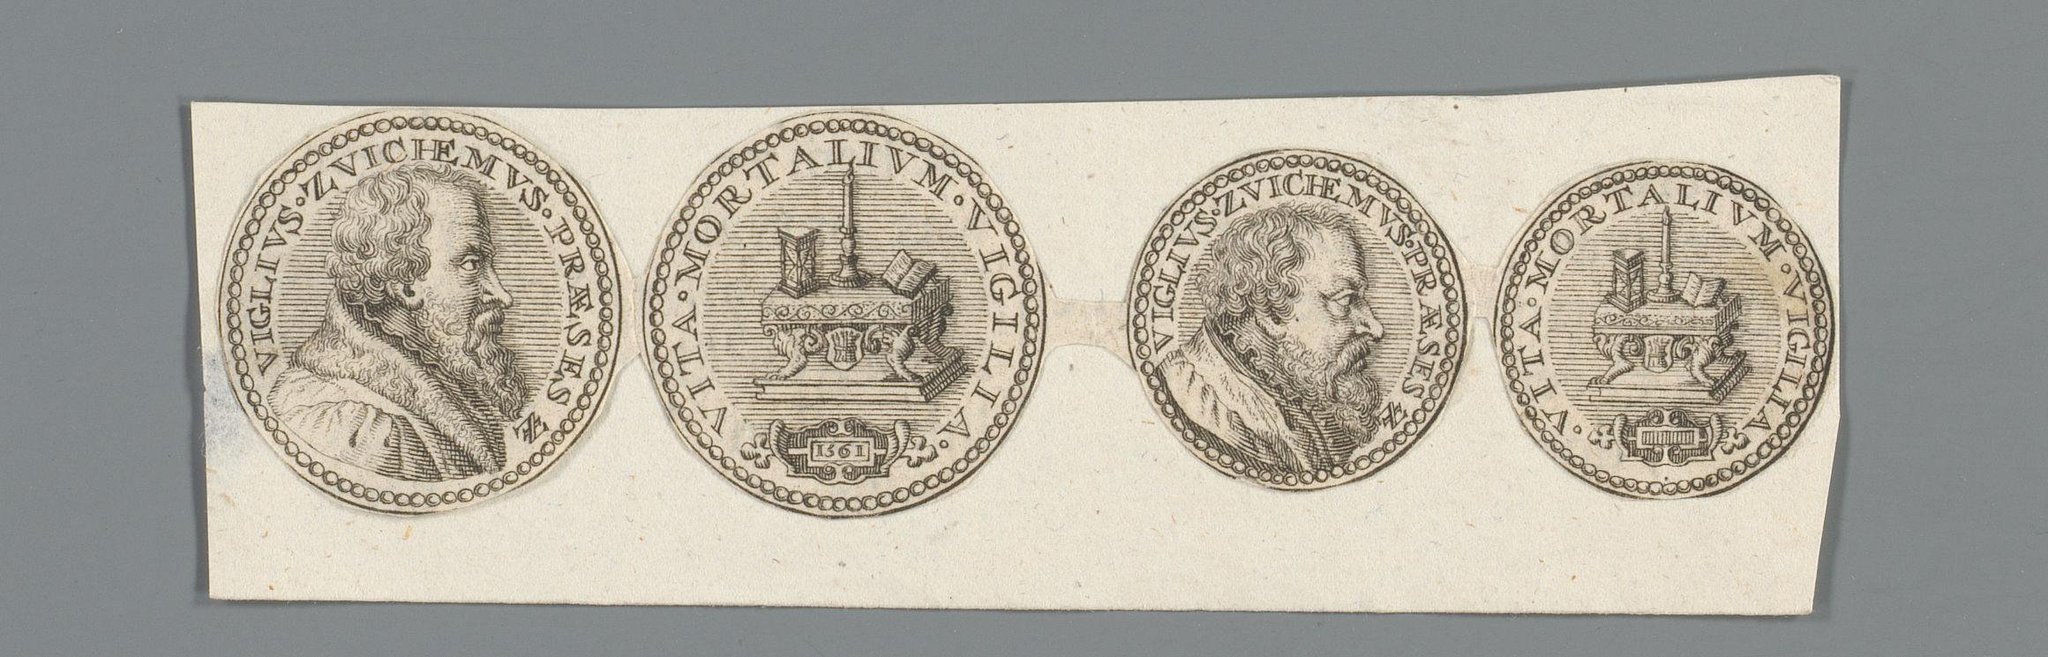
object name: print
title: Voor- en achterzijden van twee penningen met op beide het portret van Viglius Zuichemus Ab Aytta en zijn zinnebeeld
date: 1723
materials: paper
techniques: etching, letterpress printing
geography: the hague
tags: brussels, clergyman, governmental and representative bodies, symbolic representations, allegories and emblems ~mind, spirit, historical persons, coin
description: Prent uit: Loon, Gerard van. Beschryving der Nederlandsche Historipenningen: (...). Den Haag: Christiaan van Lom et al., 1723, dl. 1, p. 42.